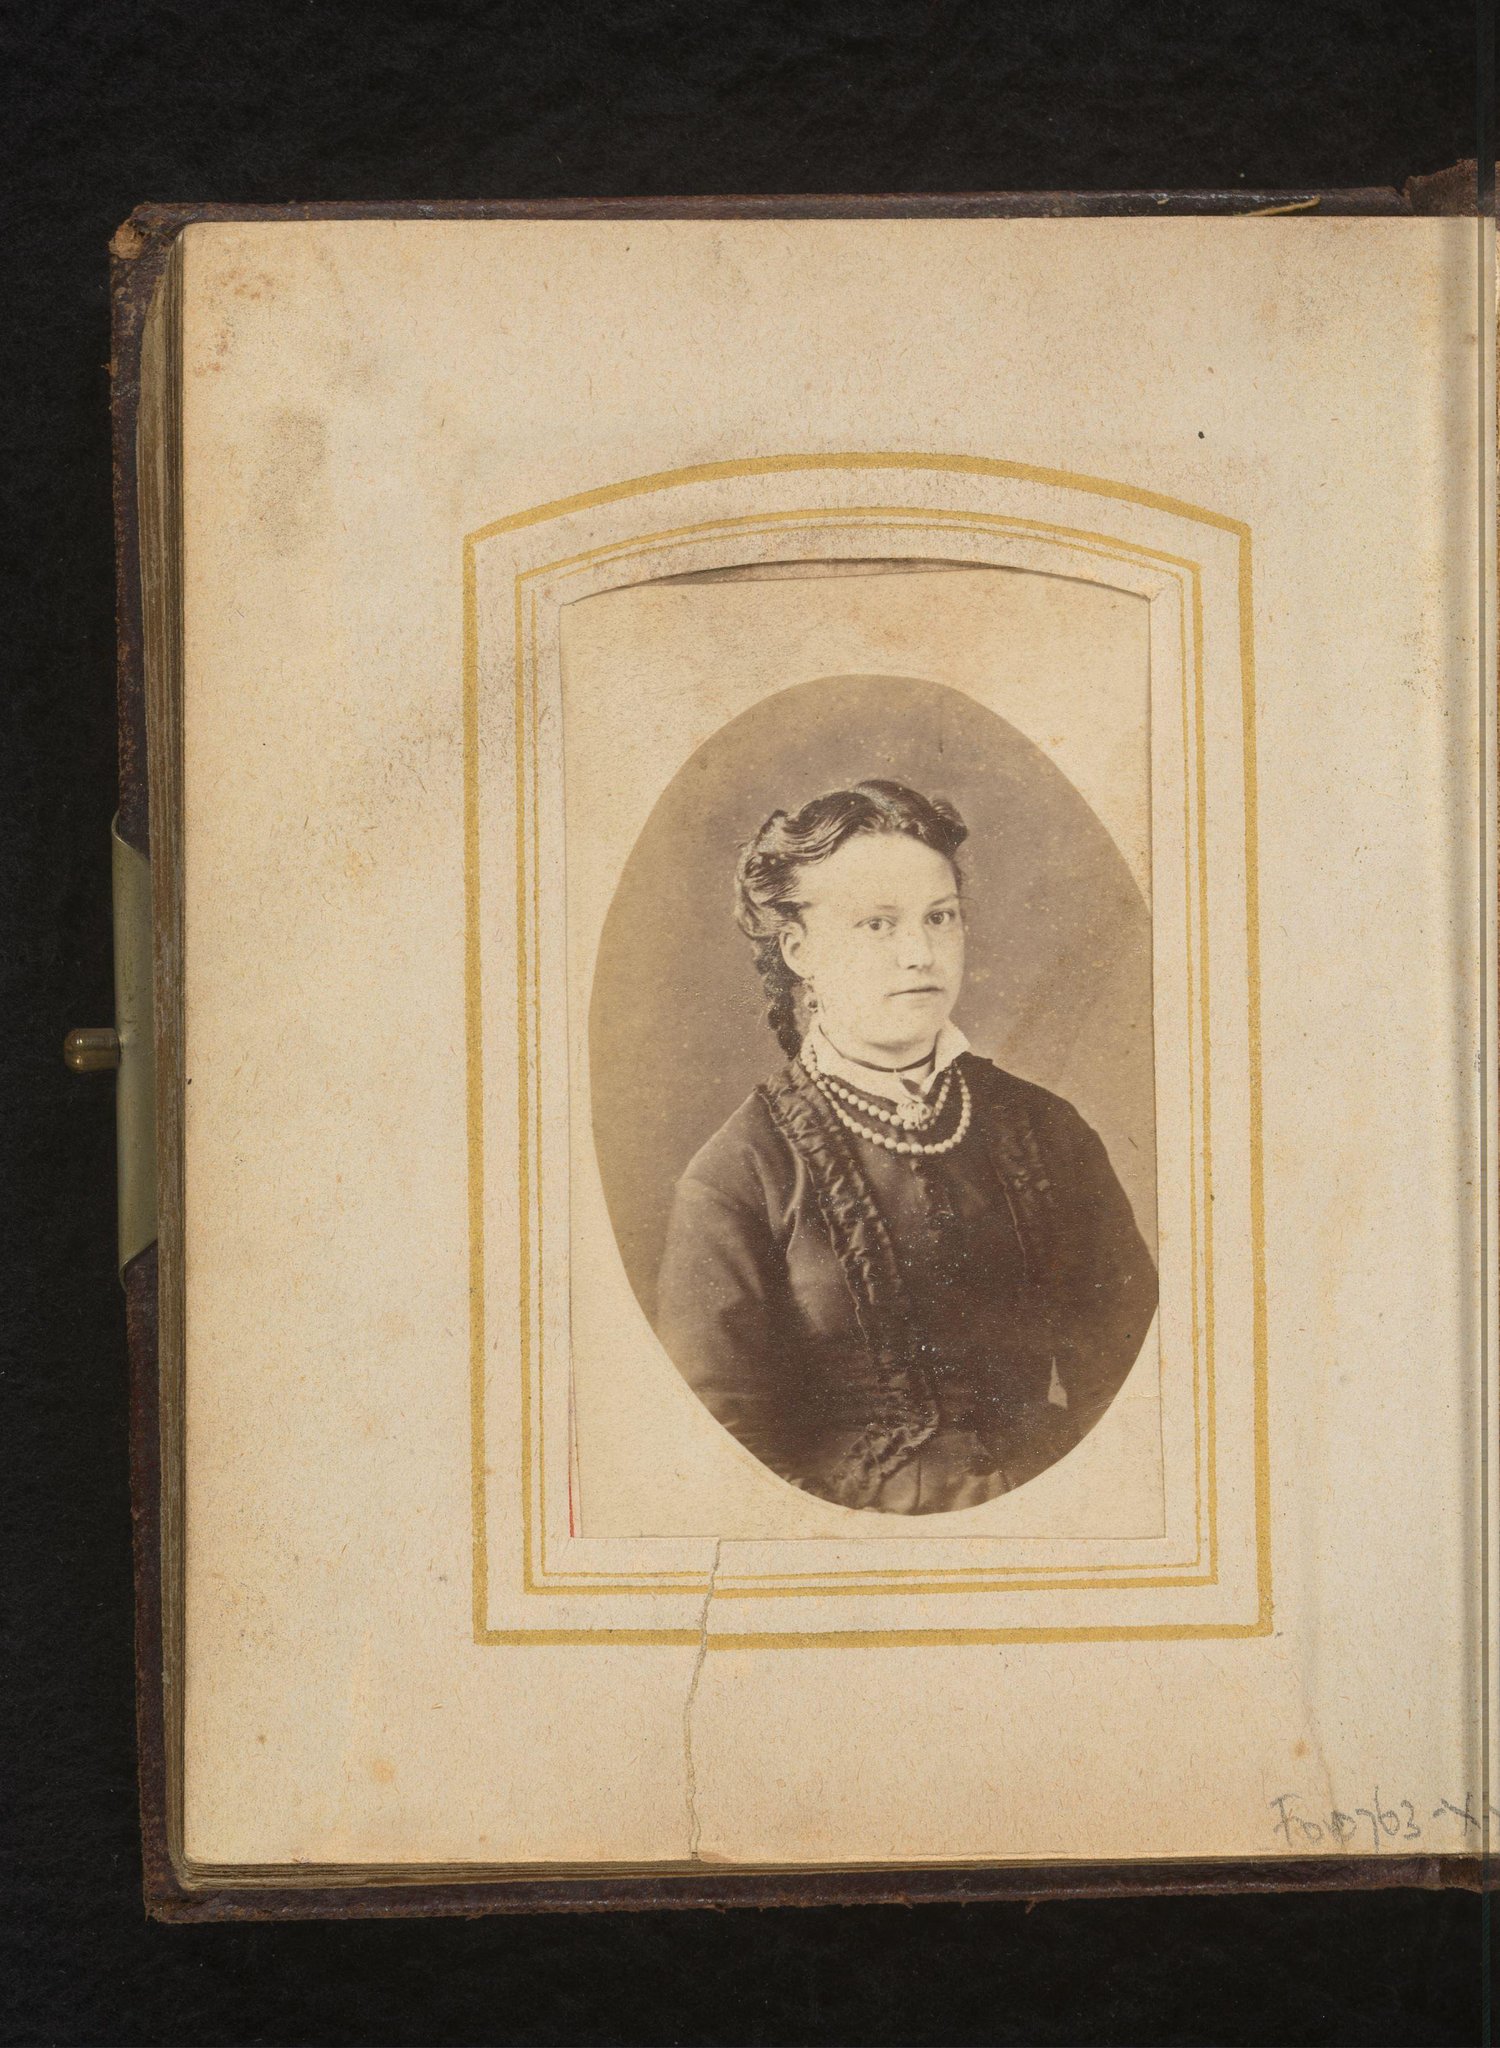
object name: album leaf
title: Portret van een zittende vrouw met halsketting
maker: arnold nelius marinus johannes fock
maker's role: fotograaf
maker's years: 1846-1901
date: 1867-1901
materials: cardboard, photographic support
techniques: albumen print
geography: utrecht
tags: sitting figure - aa - female human figure, historical persons - bb - woman, necklace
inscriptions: inscription: ‘PHOTOGR. ATELIER/ A.N.M.J. FOCK/ UTRECHT.’